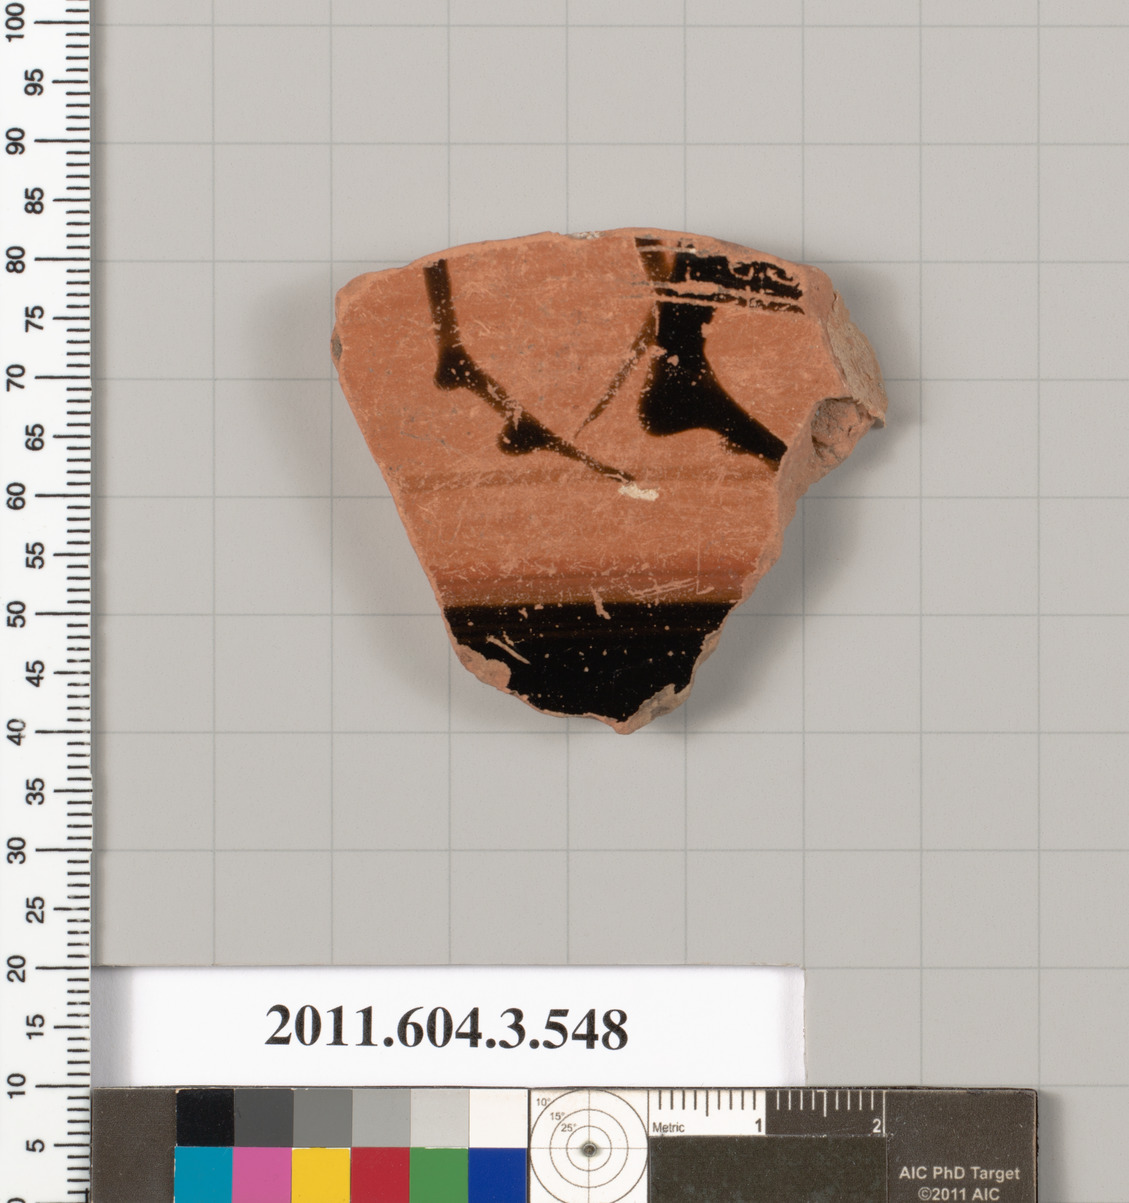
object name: column krater fragment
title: Terracotta fragment of a column-krater (bowl for mixing wine and water)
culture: greek, attic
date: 534-468 BCE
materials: terracotta